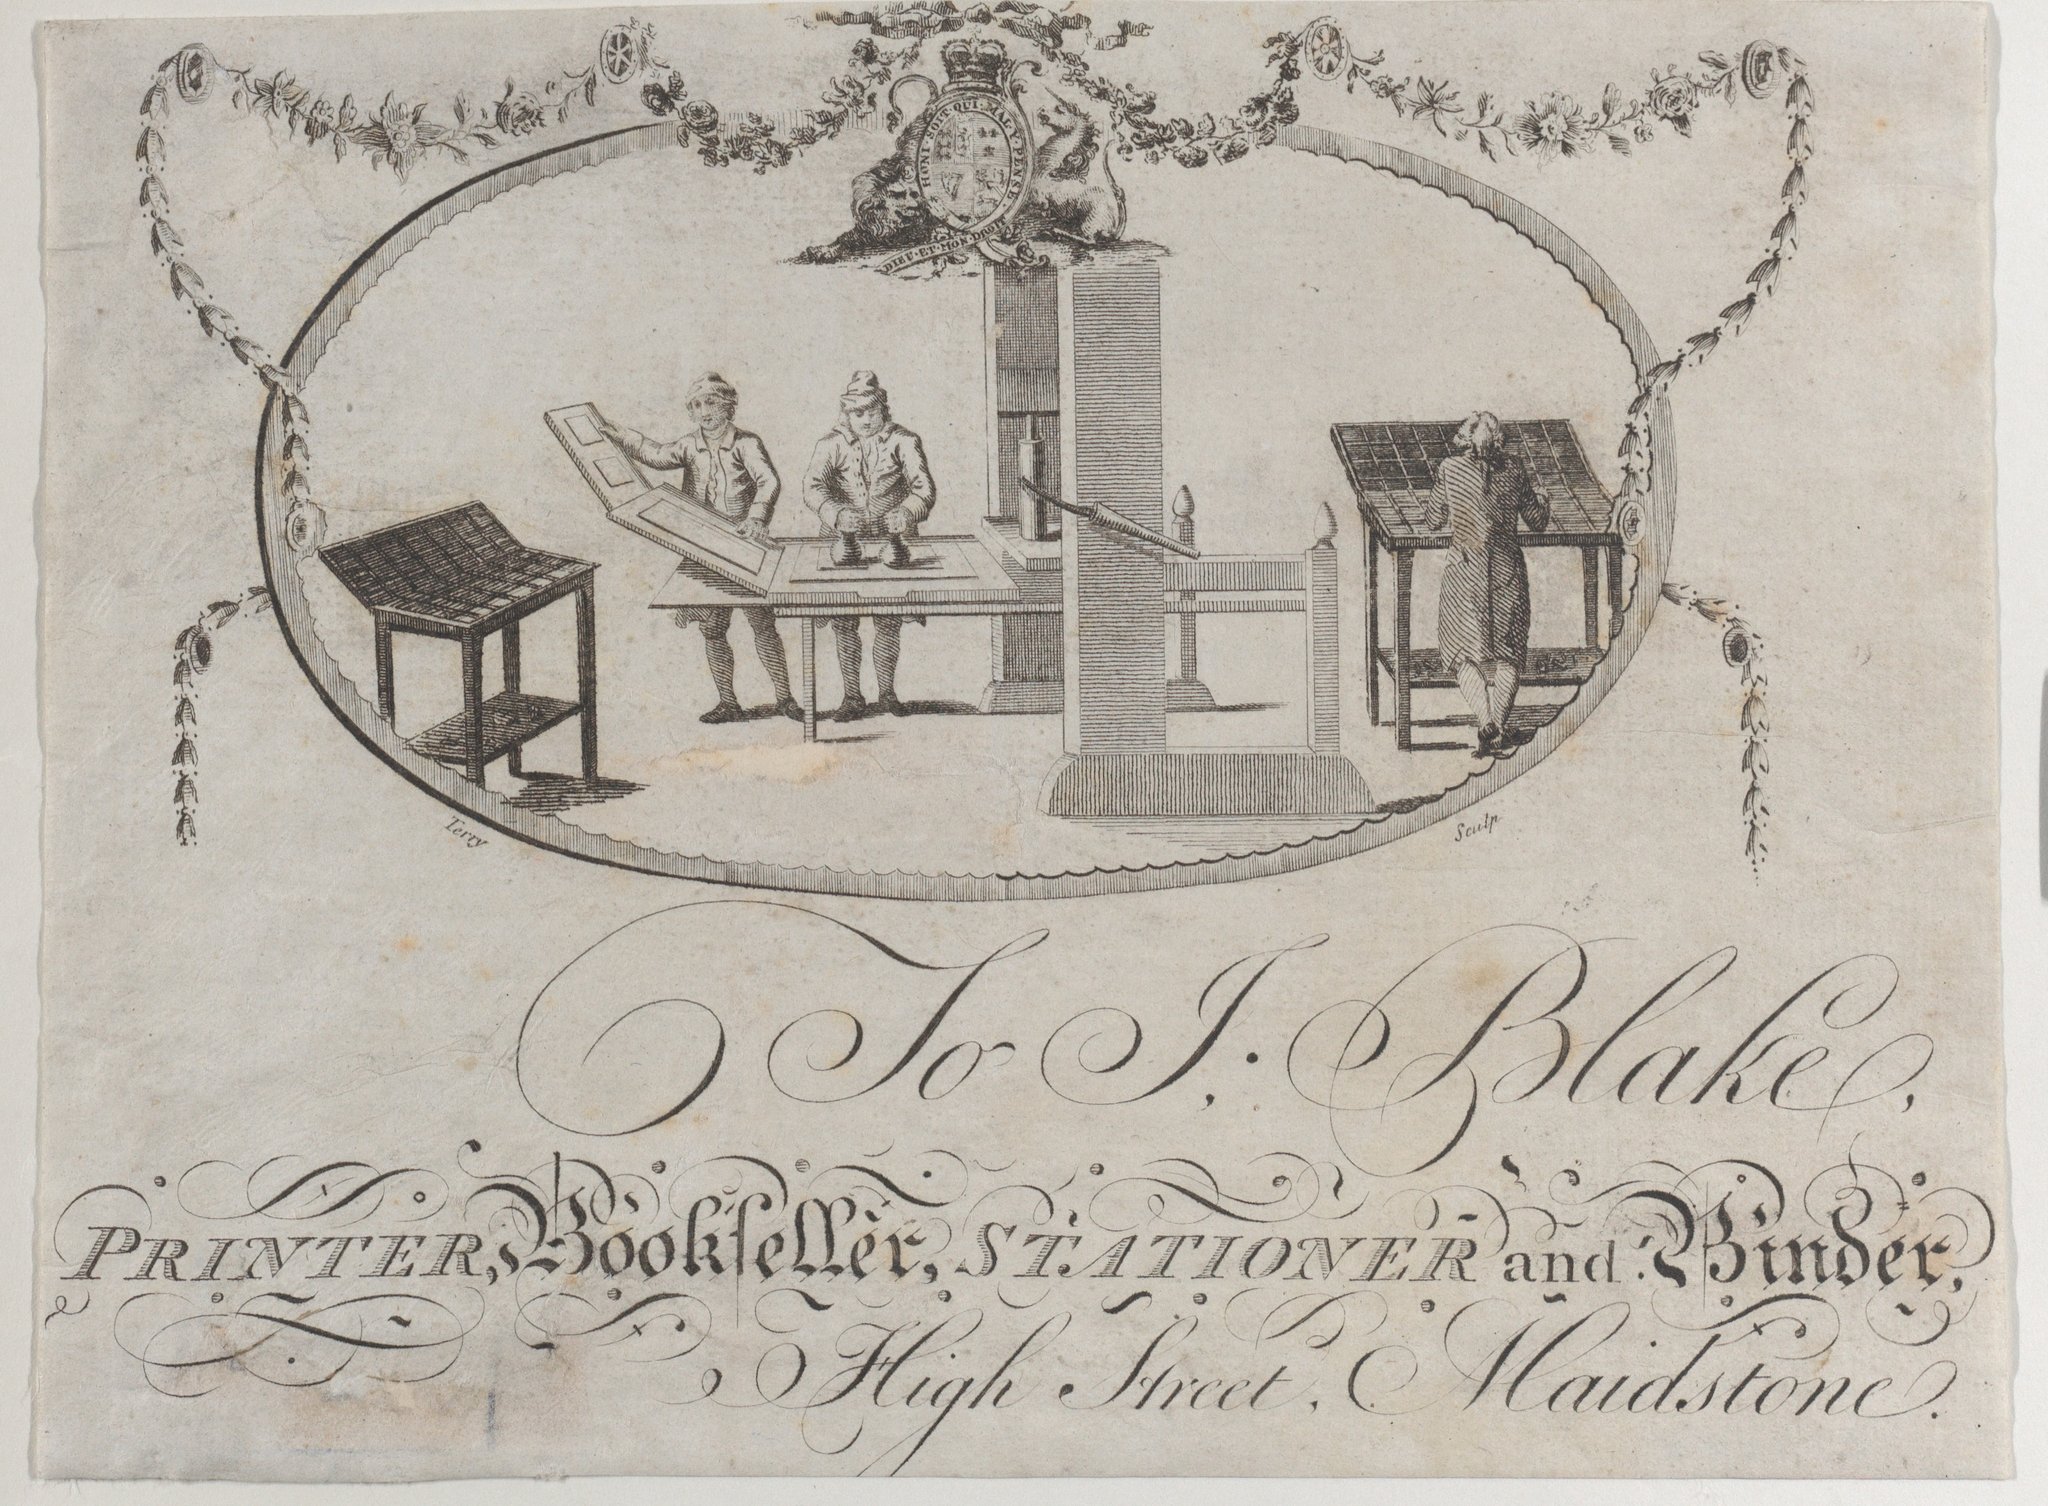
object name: print, trade card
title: Trade card for Jo J. Blake, printer, bookseller, stationer, and binder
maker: anonymous, british, 18th century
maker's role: artist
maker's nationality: british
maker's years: 1700-1800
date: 1701-1800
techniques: engraving